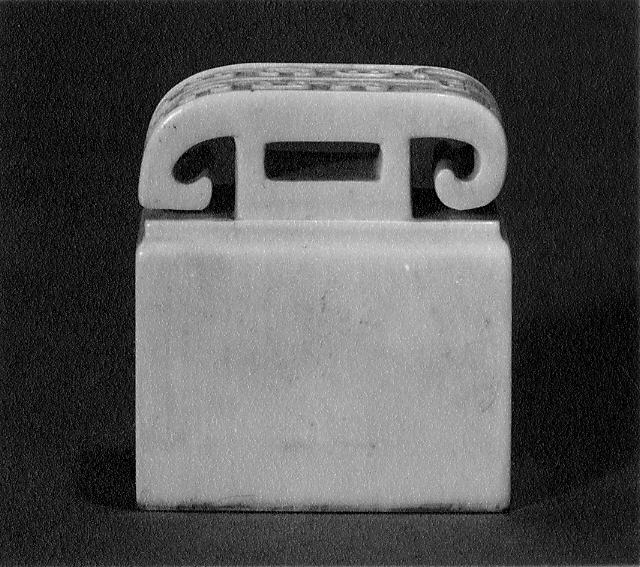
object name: seal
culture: chinese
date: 1701-1800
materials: ivory